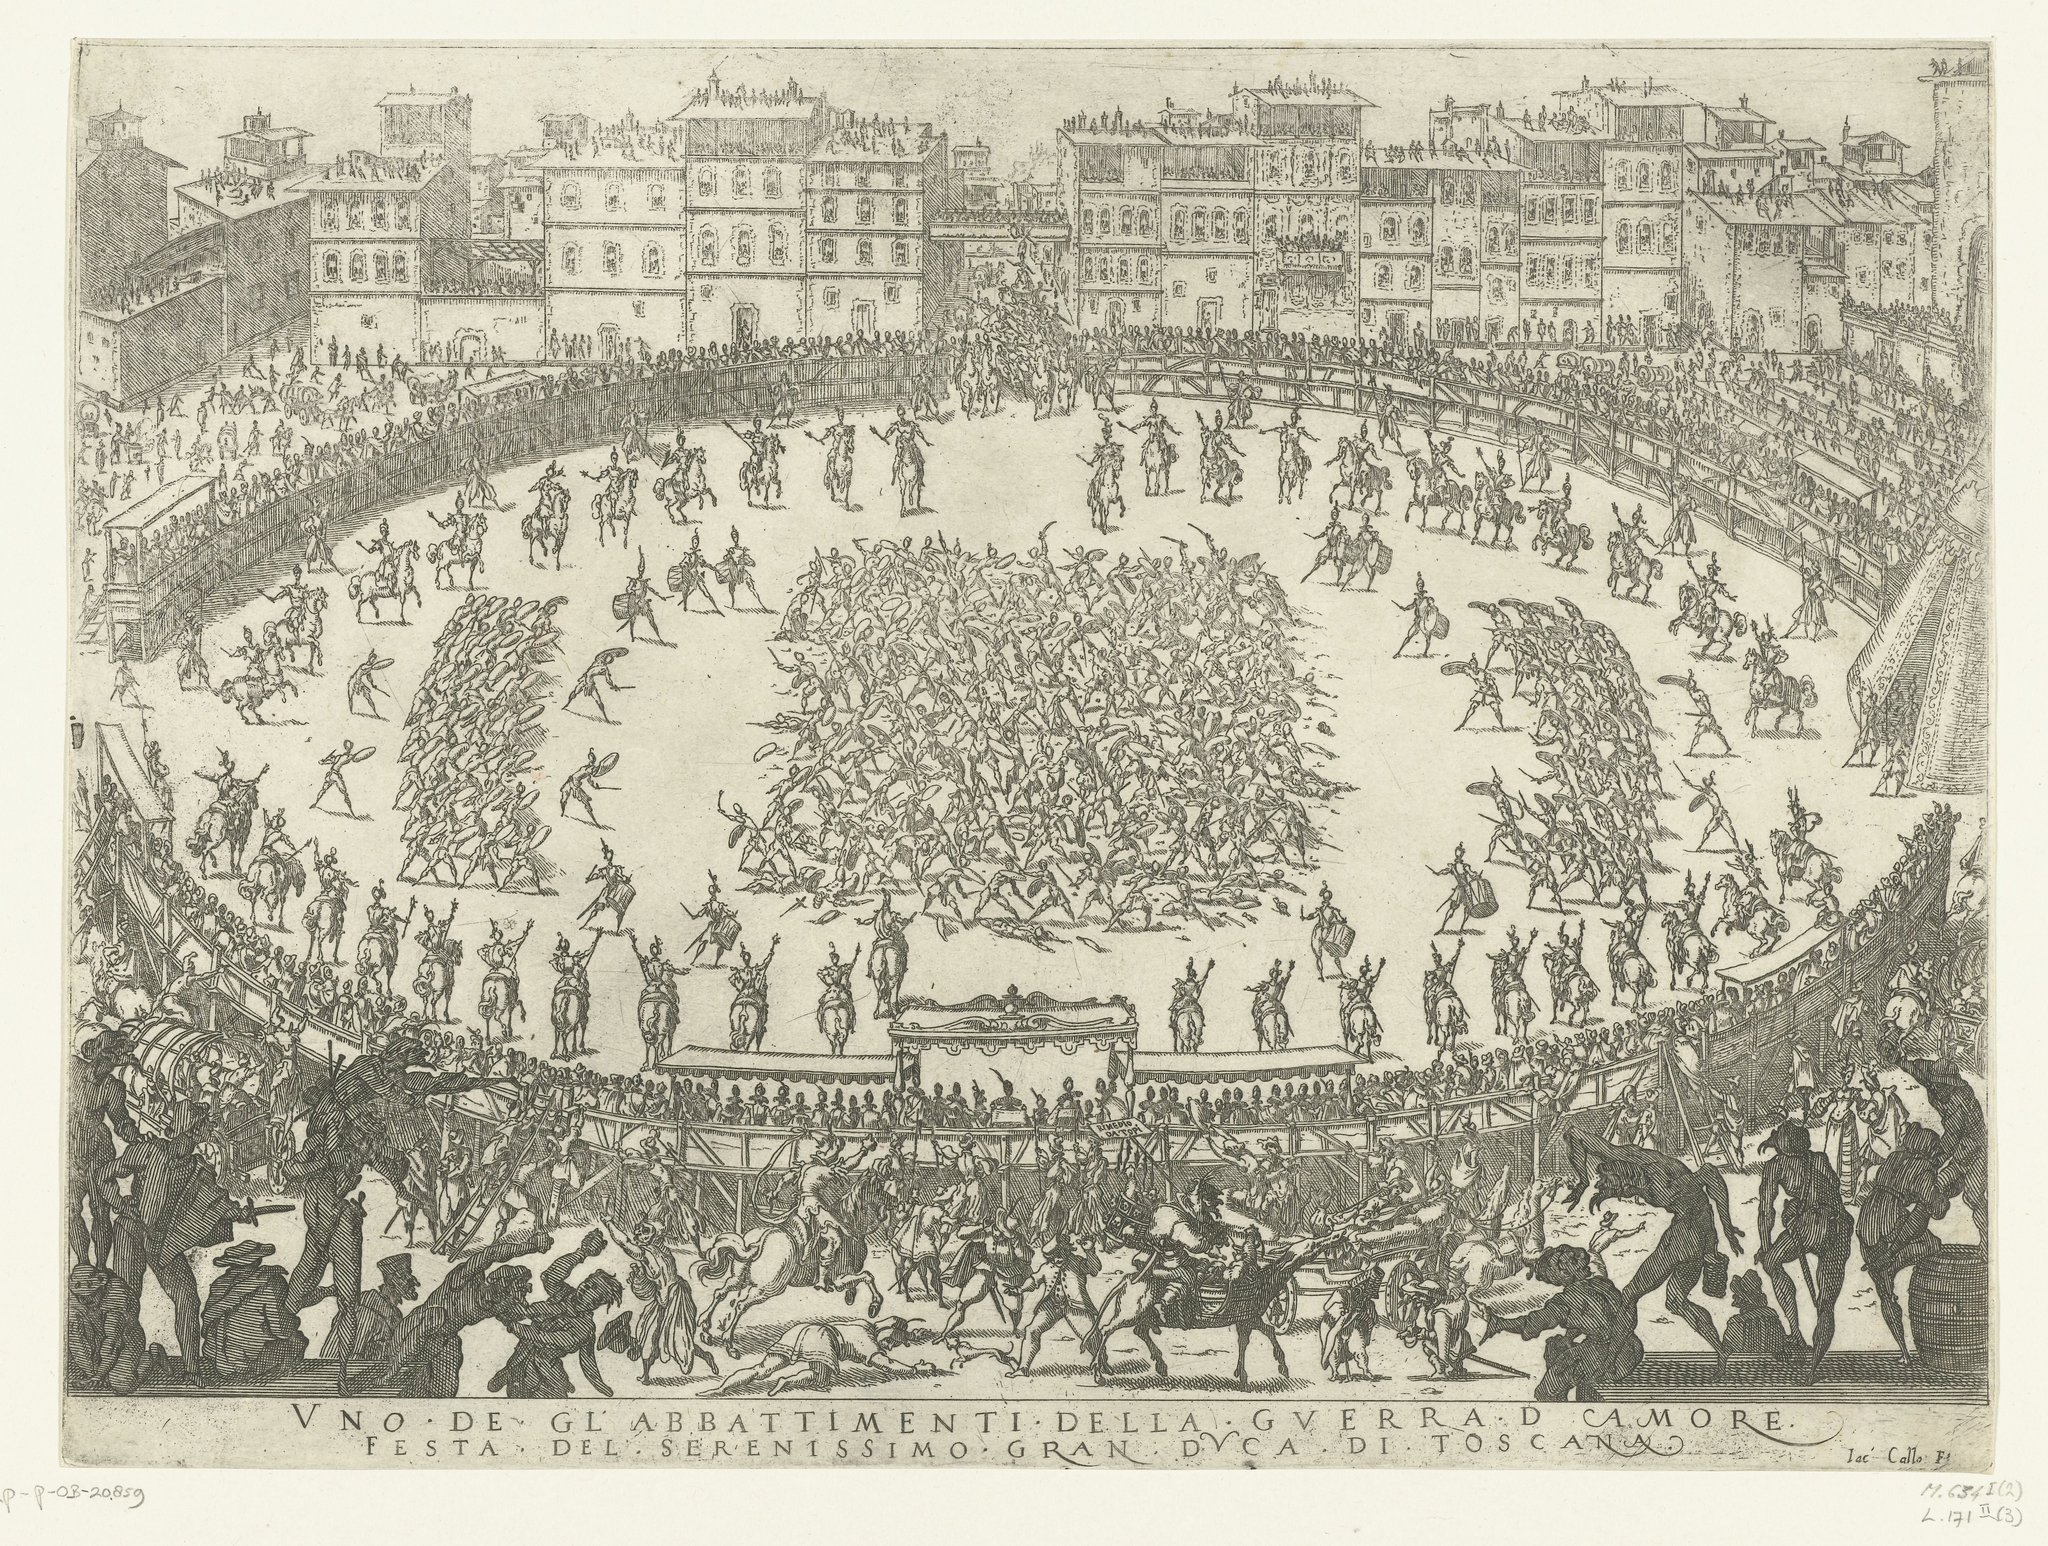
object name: print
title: Carnaval te Florence: infanteriegevecht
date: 1616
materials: paper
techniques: etching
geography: florence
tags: cosimo ii de' medici, hand-to-hand fighting (~ battle), carnival, shrovetide (non-liturgical celebration), village square, place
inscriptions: collector's mark: Lugt 240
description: Gezicht op de Piazza Santa Croce in Florence, waar soldaten een schijngevecht uitvoeren voor toeschouwers, die op in ovaalvorm geplaatst tribunes zitten. Dit gevecht vond plaats tijdens het carnavalsfeest 'Guerra d'Amore', dat Cosimo II de' Medici in 1616 in Florence gaf. Onder de voorstelling twee regels Italiaanse tekst.